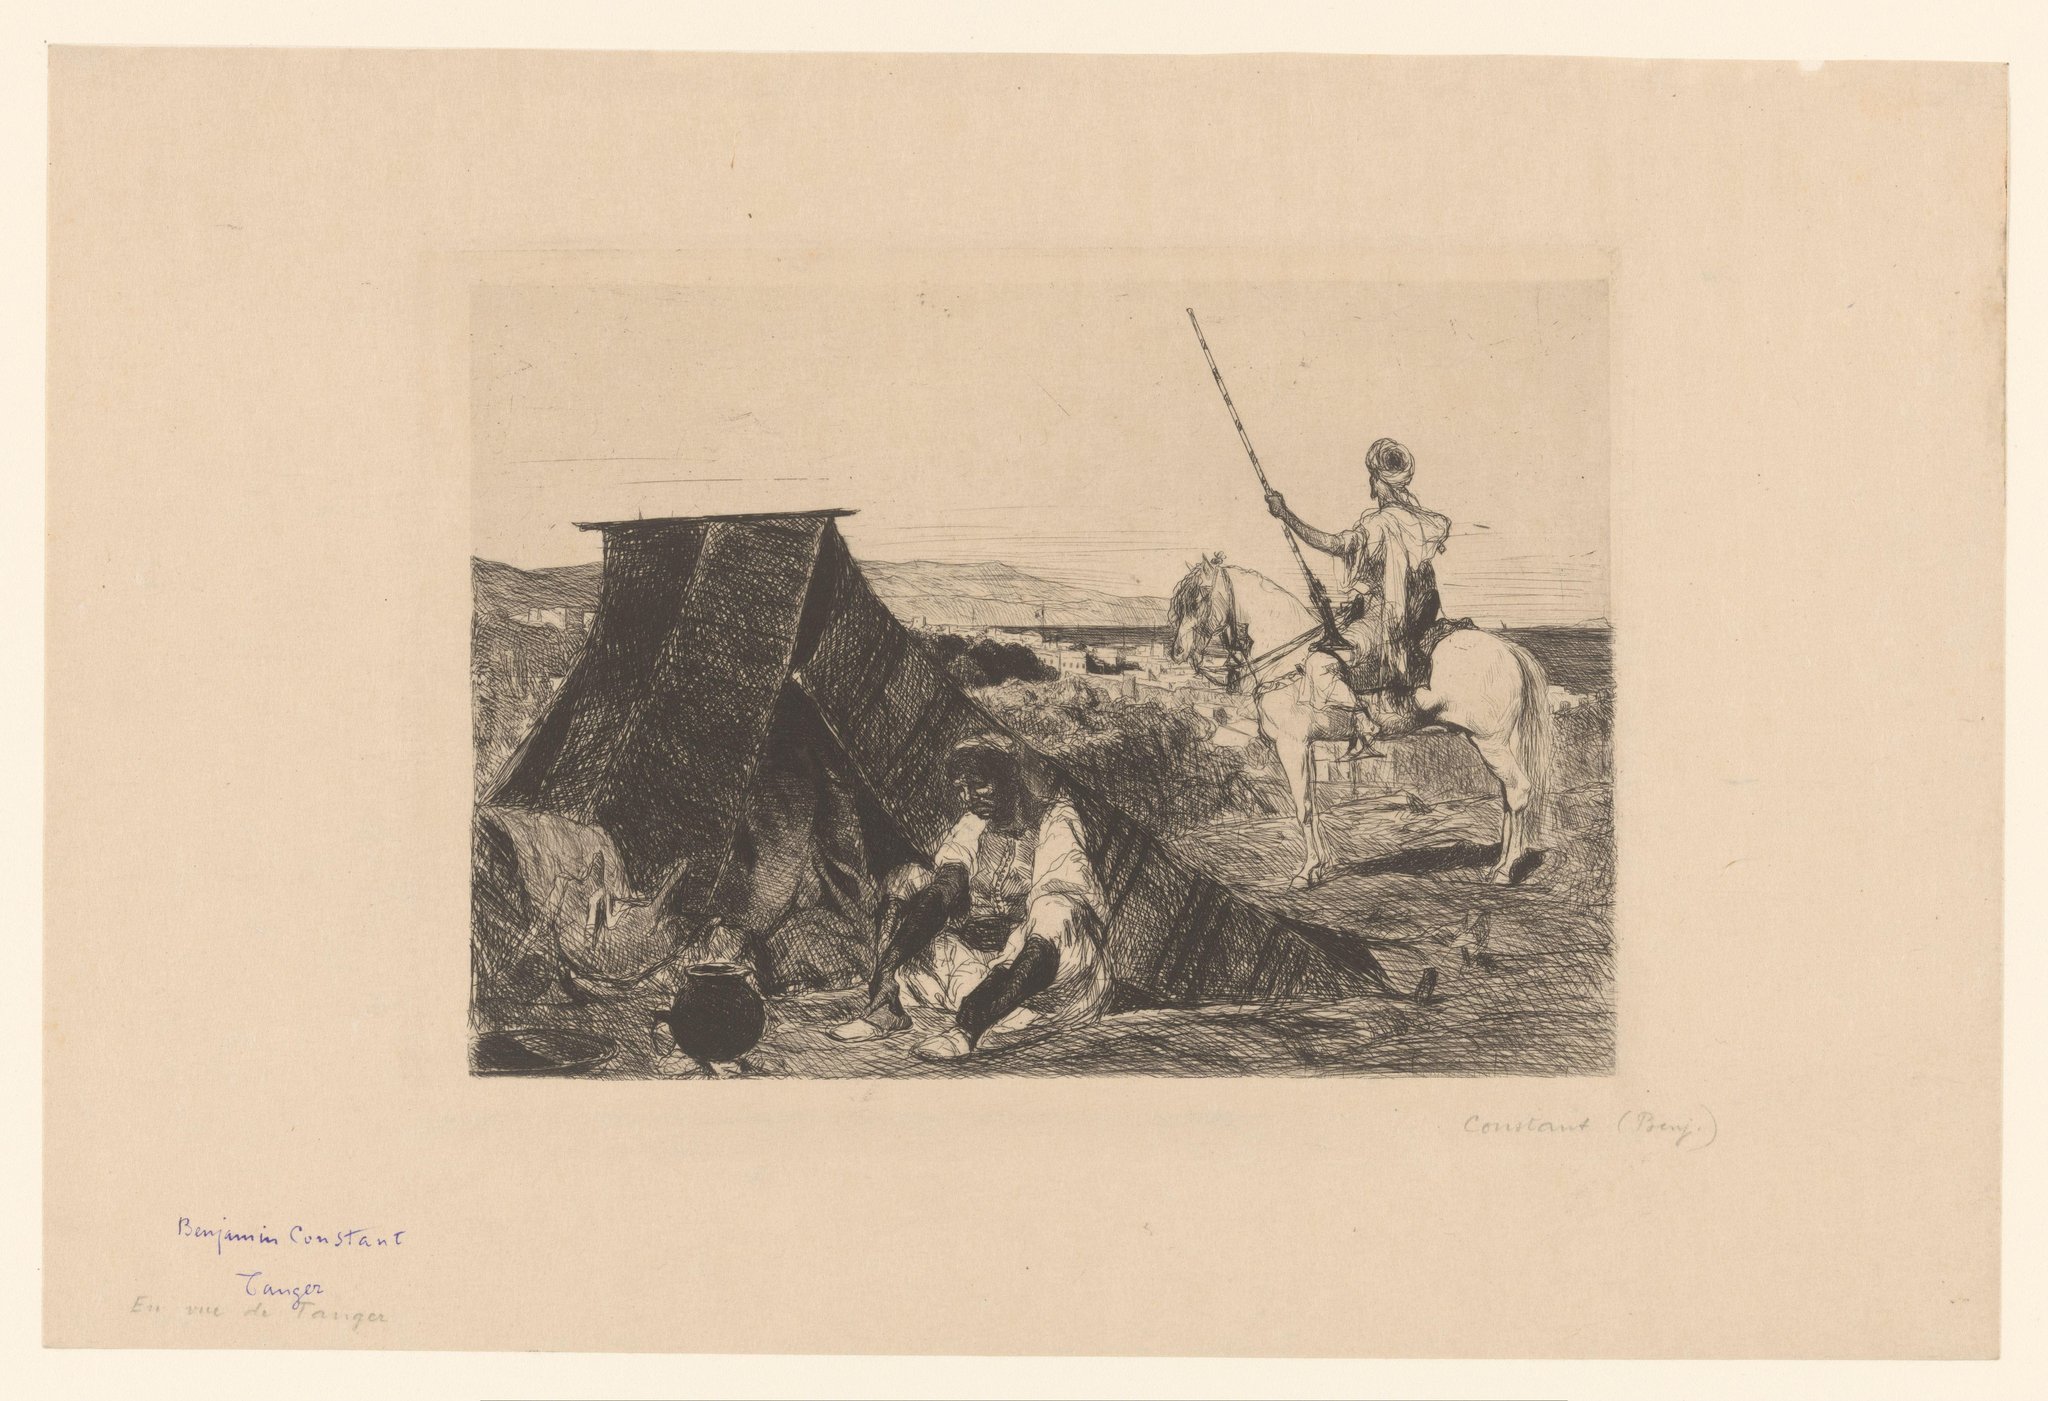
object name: print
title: L'Eau-Forte en 1877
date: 1877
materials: paper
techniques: drypoint, etching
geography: france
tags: riding a horse, ass, or mule; rider, horseman, landscapes, tent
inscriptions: collector's mark: Lugt 2228